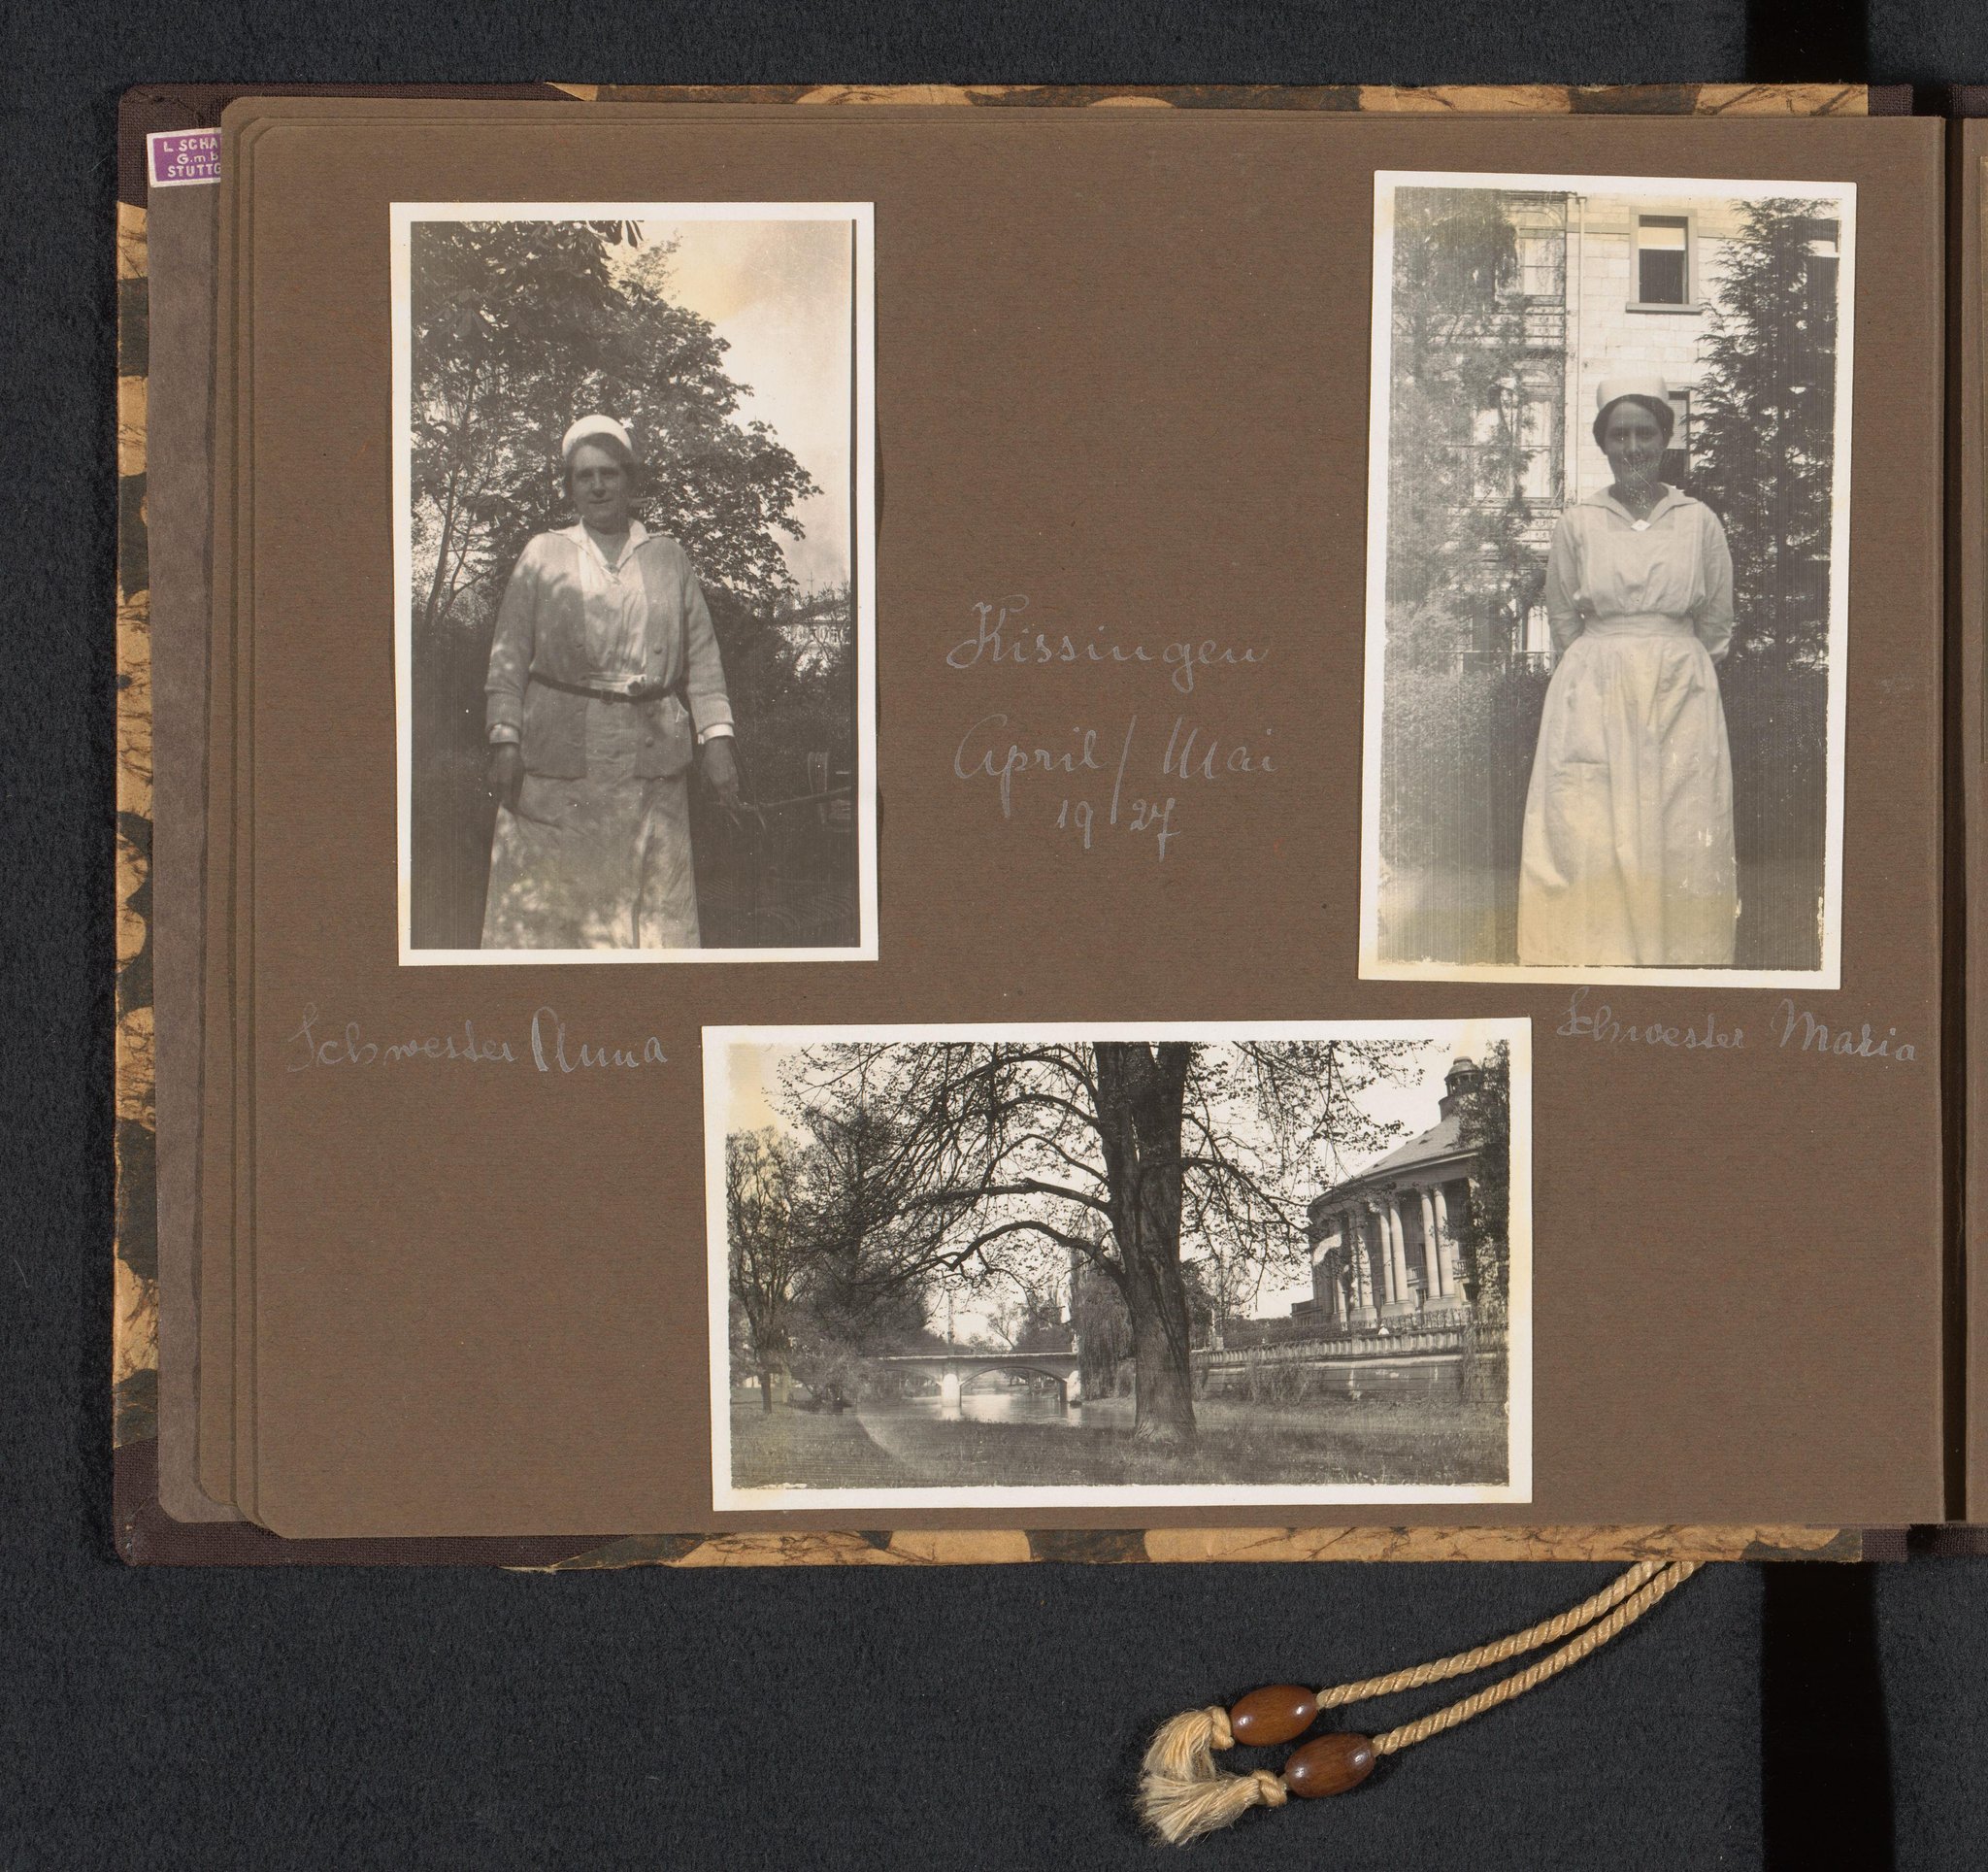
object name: album leaf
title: Twee verpleegsters bij het badhuis van Luitpoldbad, april-mei 1927, Bad Kissingen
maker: else wachenheimer-moos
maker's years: 1895-1944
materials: paper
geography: bad kissingen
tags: beieren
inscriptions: inscription: ‘Luitpoldbad Kissingen’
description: Albumblad bevat drie foto's van twee onbekende verpleegsters. Afkomstig uit album half formaat, kartonomslag met koordbinding en lichte veelvormige vormen op voorzijde.